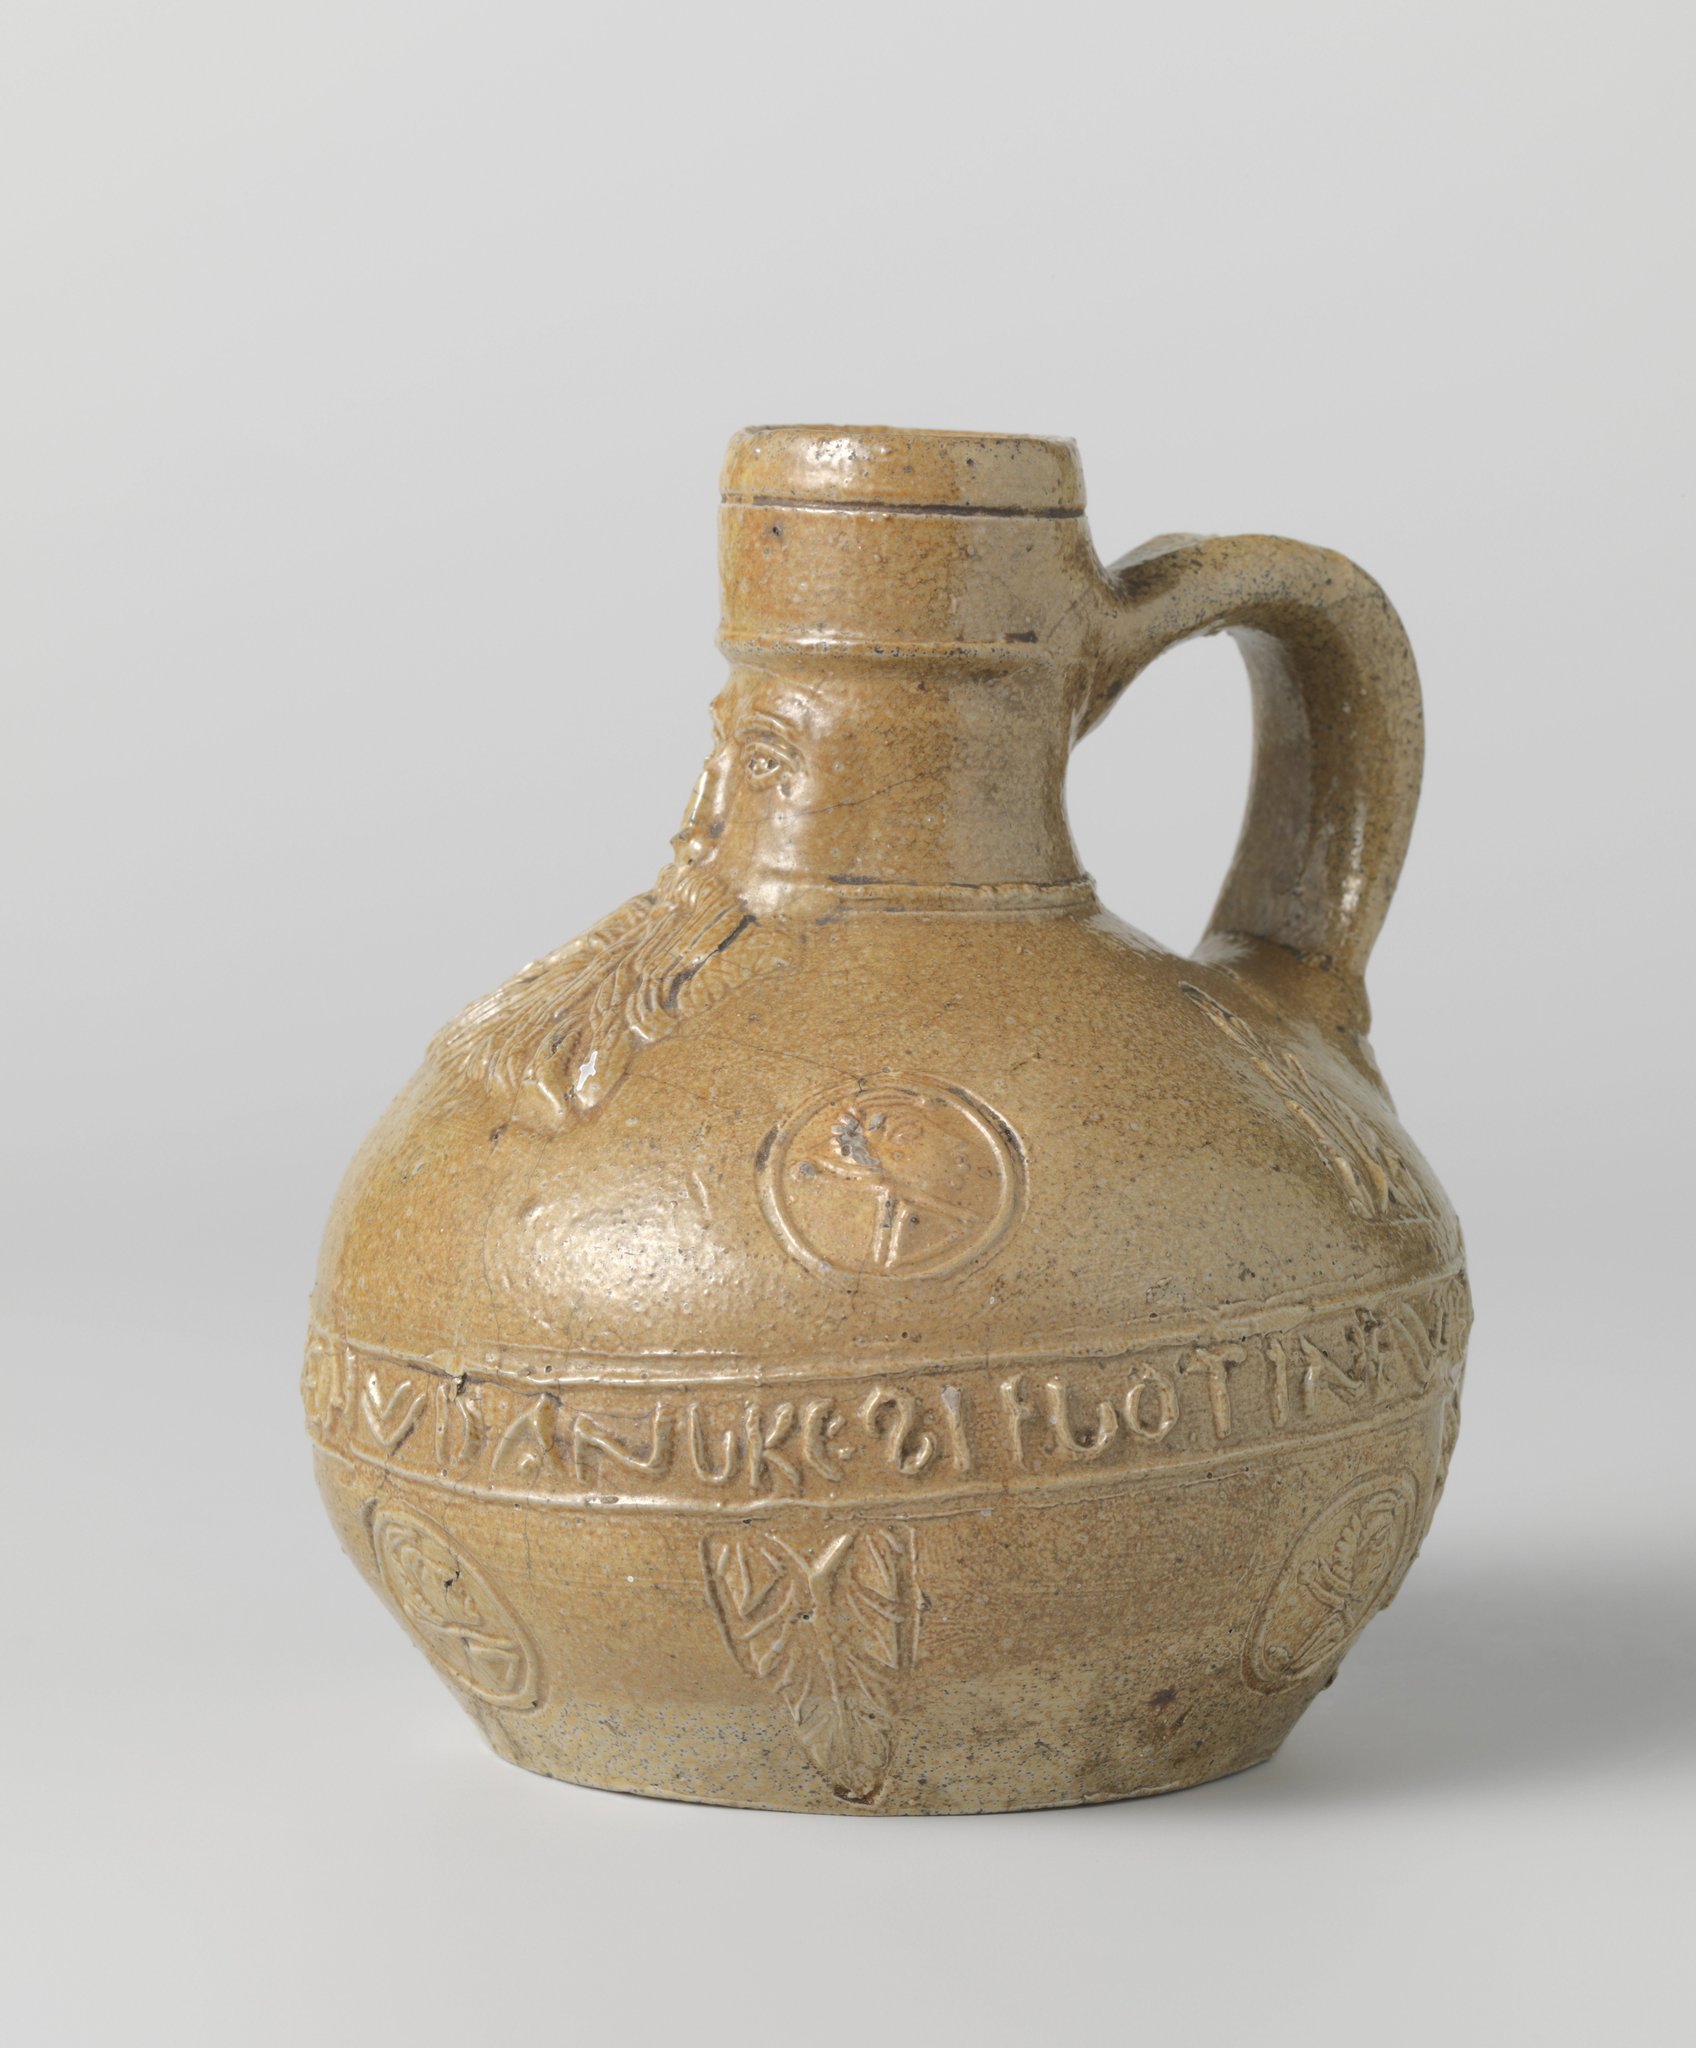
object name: jug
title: Bartmann (bearded-man) jug with medallions and letters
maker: Anonymous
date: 1550-1624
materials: engobe, glaze, stoneware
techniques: firing, forming, relief, turning, vitrification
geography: frechen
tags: foliage ~ ornament, beard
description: Kruik (baardmankruik) van steengoed op standvlak met een bolvormig lichaam en wijde nek. Het C-vormige oor is bevestigd aan de nek en de schouder. Profielen op de nek. Bedekt met een bruine engobe. Op de buik in reliëf een gedrukte en opgelegde decoratieve band met een nietszeggend opschrift. Aan weerszijden van het opschrift medaillons met portretten en profil en bladmotieven. Op de nek, doorlopend op de schouder, een baardman. Frechen.